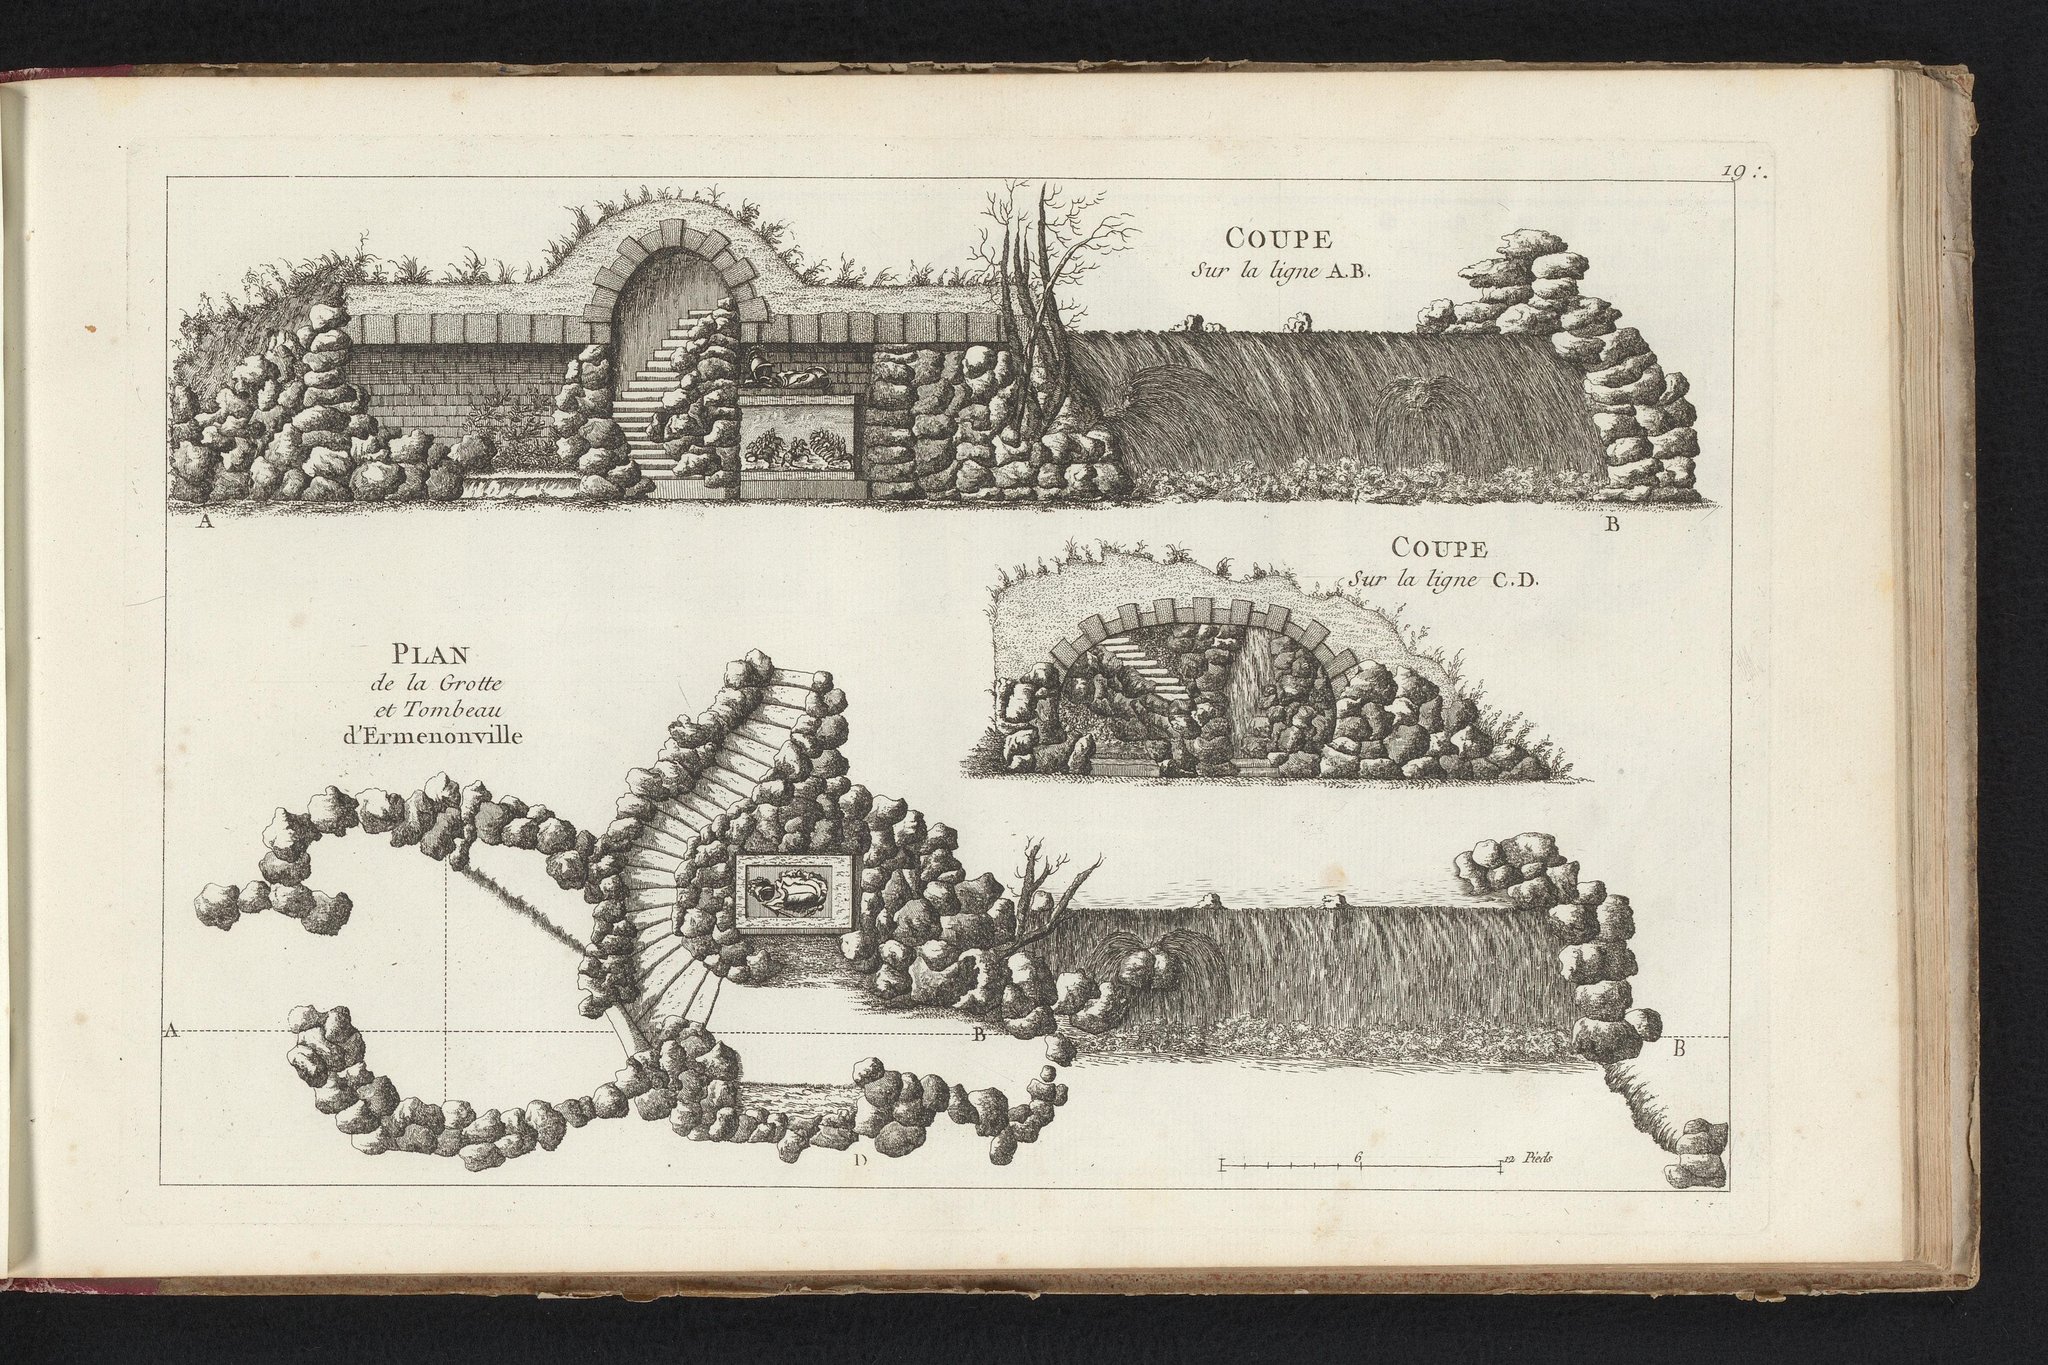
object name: album leaf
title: Jardins anglo-chinois à la mode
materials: paper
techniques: engraving, etching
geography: paris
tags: grave, tomb, lay-out of garden, cave, grotto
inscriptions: collector's mark: Lugt 2228, collector's mark: Lugt 2760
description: De serie 'Jardins anglo-chinois à la mode' verscheen in totaal in 21 zogeheten 'cahiers' (afleveringen). De huidige prent komt uit het derde 'cahier'. Het Rijksmuseum Amsterdam bezit drie banden met daarin in totaal zes 'cahiers' van deze reeks. In de documentatie wordt verwezen naar een in de bibliotheek van het Rijksmuseum Amsterdam aanwezige facsimile van het complete werk.